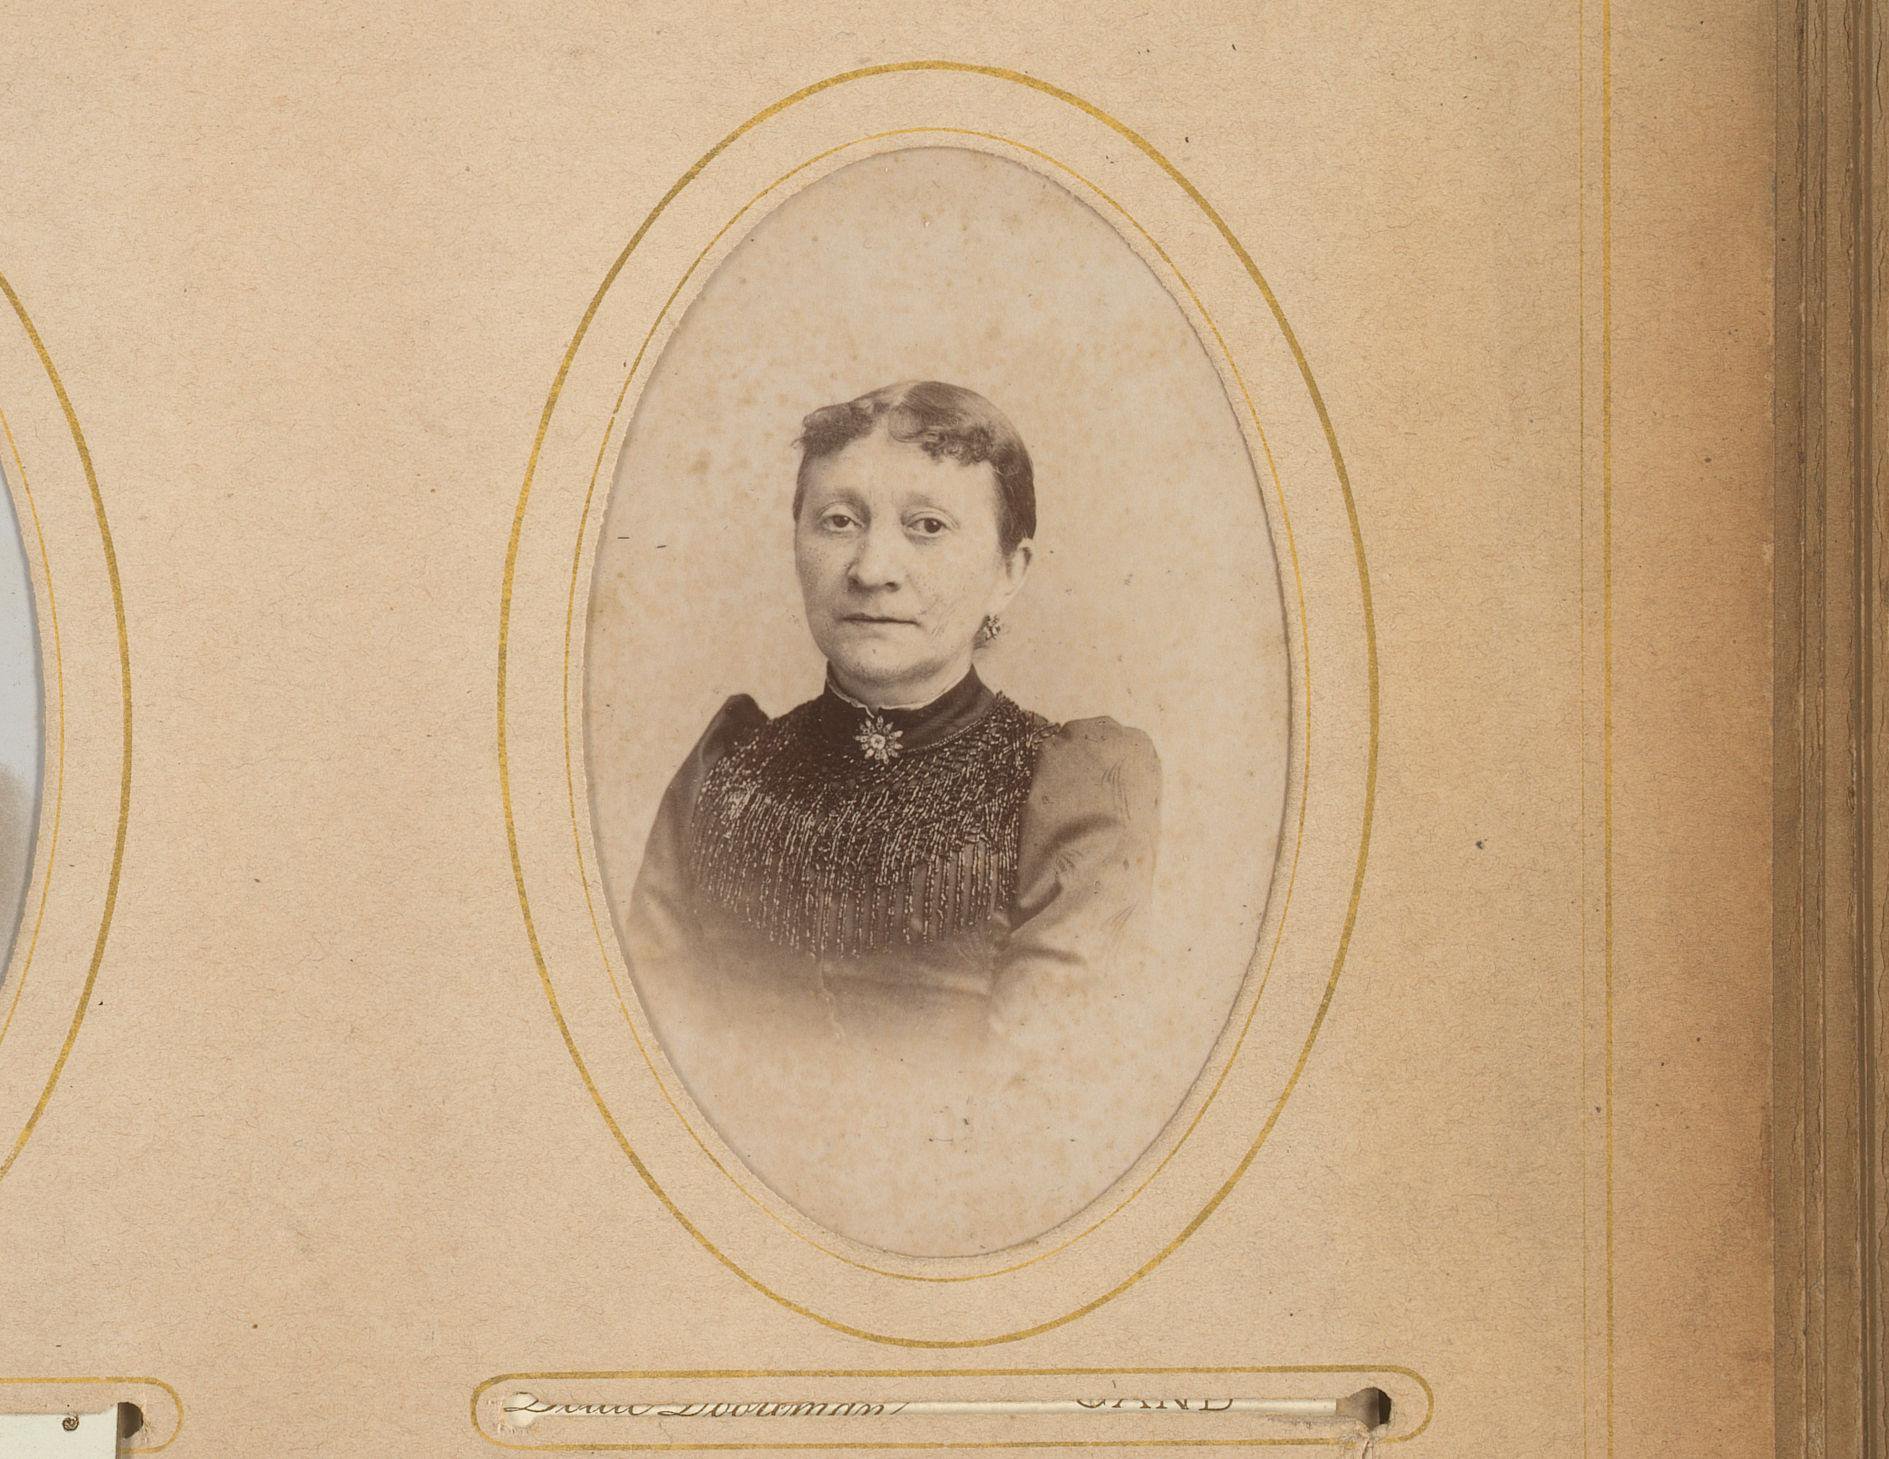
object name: carte de visite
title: Portret van een vrouw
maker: henri boute-dooreman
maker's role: fotograaf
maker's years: 1838-1894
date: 1880-1910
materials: cardboard, photographic support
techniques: albumen print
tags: adult woman, historical persons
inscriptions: name: ‘Boute Dooreman Gand’